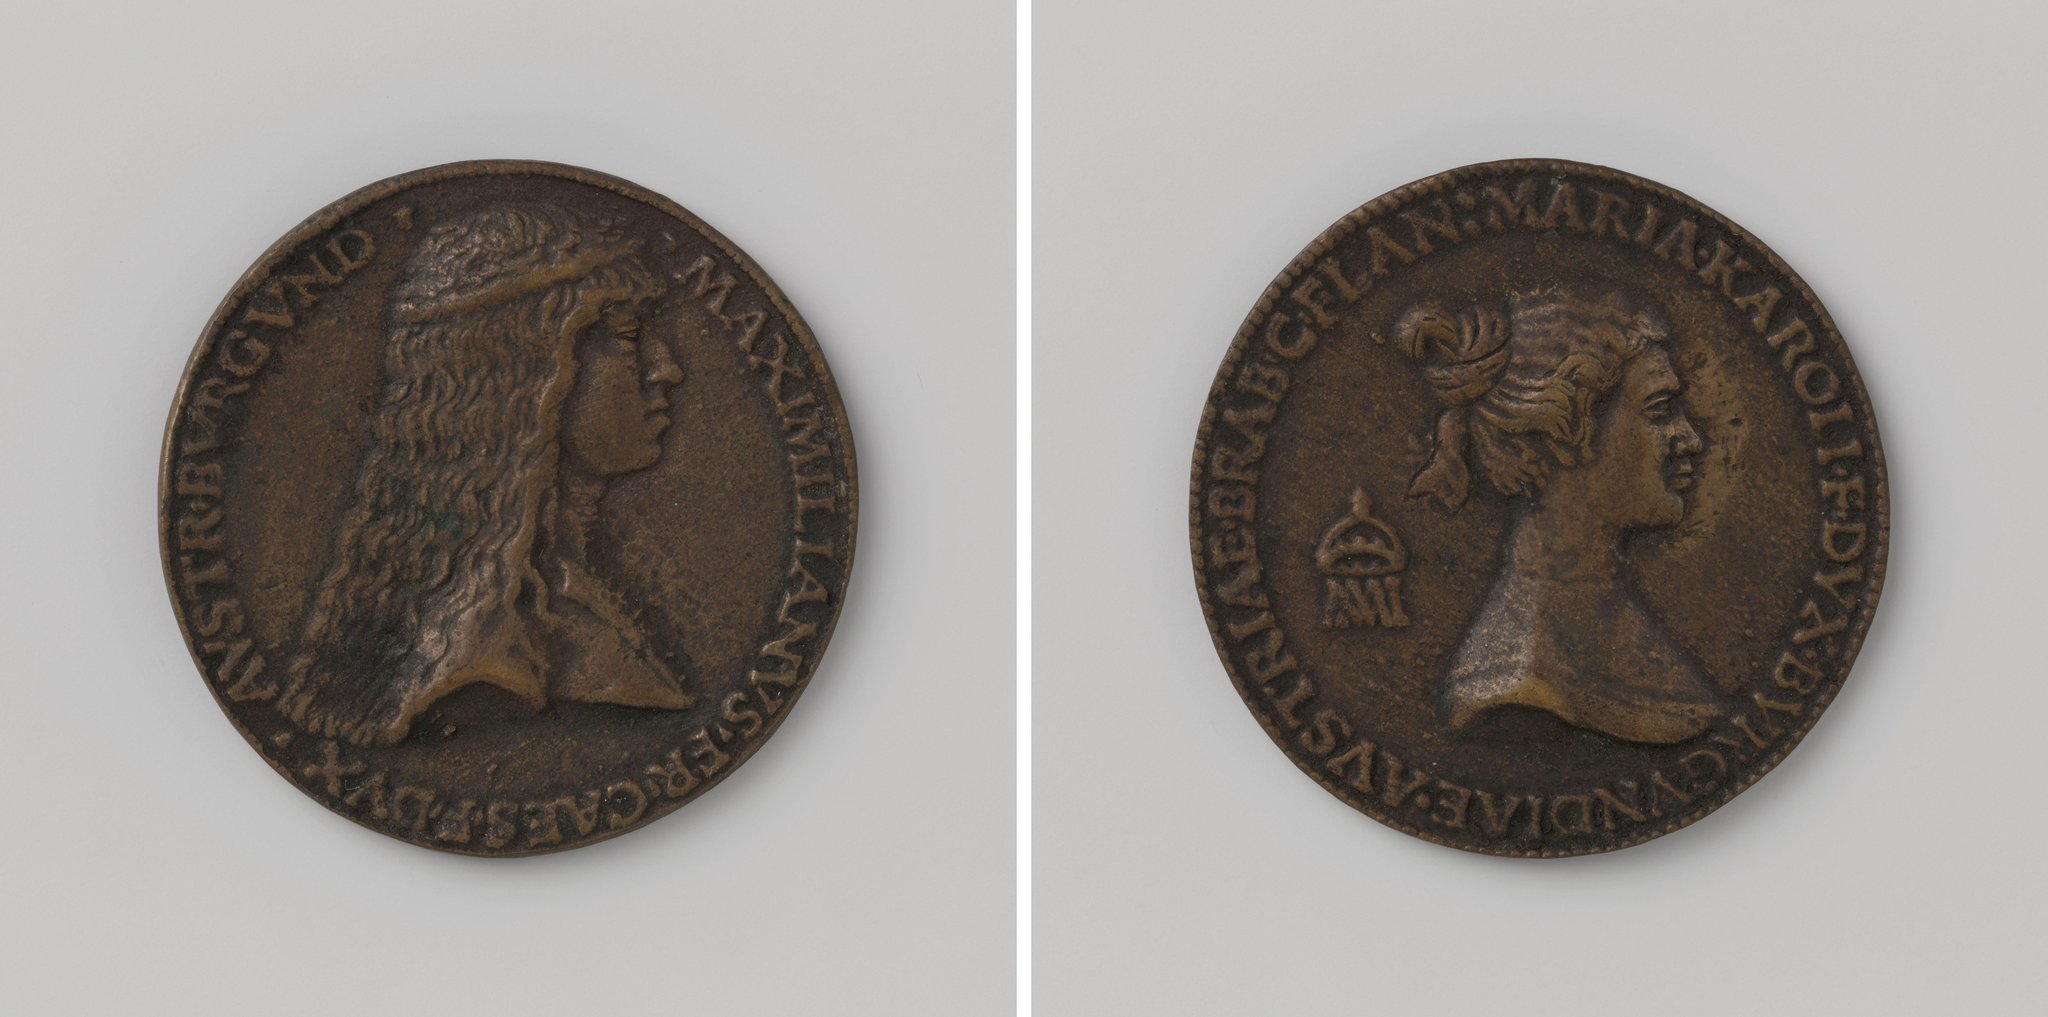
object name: copy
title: Maximiliaan, aartshertog van Oostenrijk en Maria, hertogin van Bourgondie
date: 1479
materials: bronze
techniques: casting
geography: bruges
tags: brussels, bruges, maria (hertogin van bourgondië), maximilian i (holy roman emperor)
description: Bronzen penning. Voorzijde: borststuk man met lauwerkrans binnen omschrift. Keerzijde: borststuk vrouw naast gekroond monogram binnen omschrift